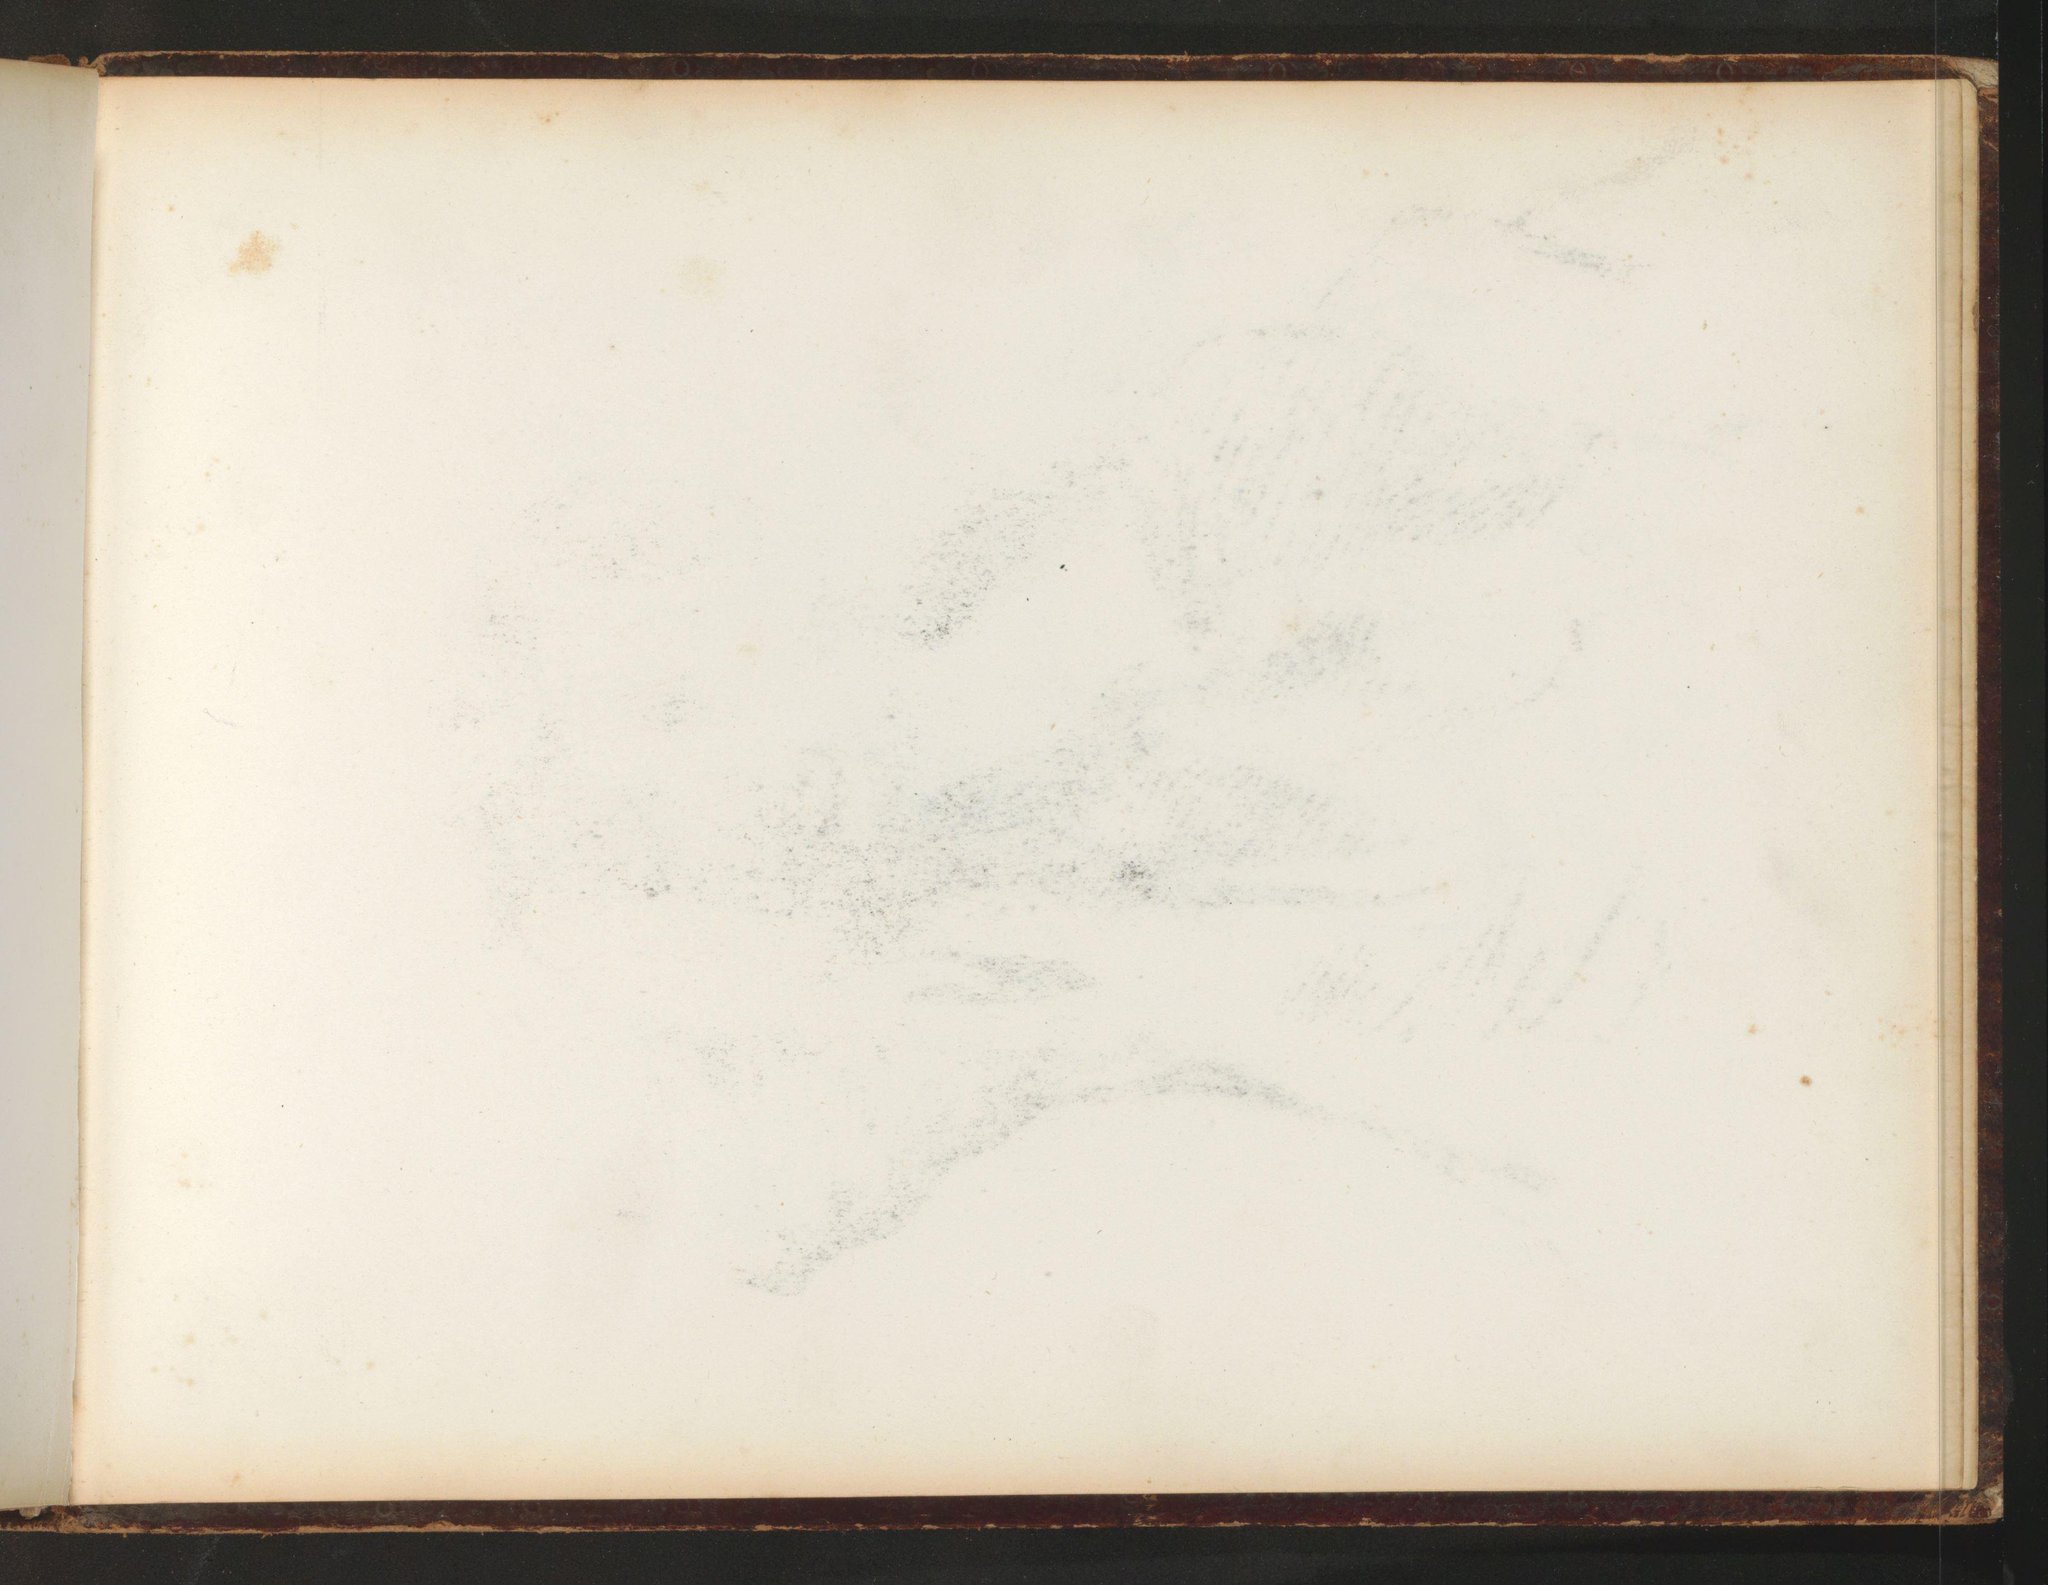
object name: sketchbook leaf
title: Abklatsch van een krijttekening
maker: reinier craeyvanger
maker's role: draughtsman, print maker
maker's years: 1812-1880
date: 1822-1880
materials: paper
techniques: printmaking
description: Blad 43 recto uit een schetsboek met 45 bladen.